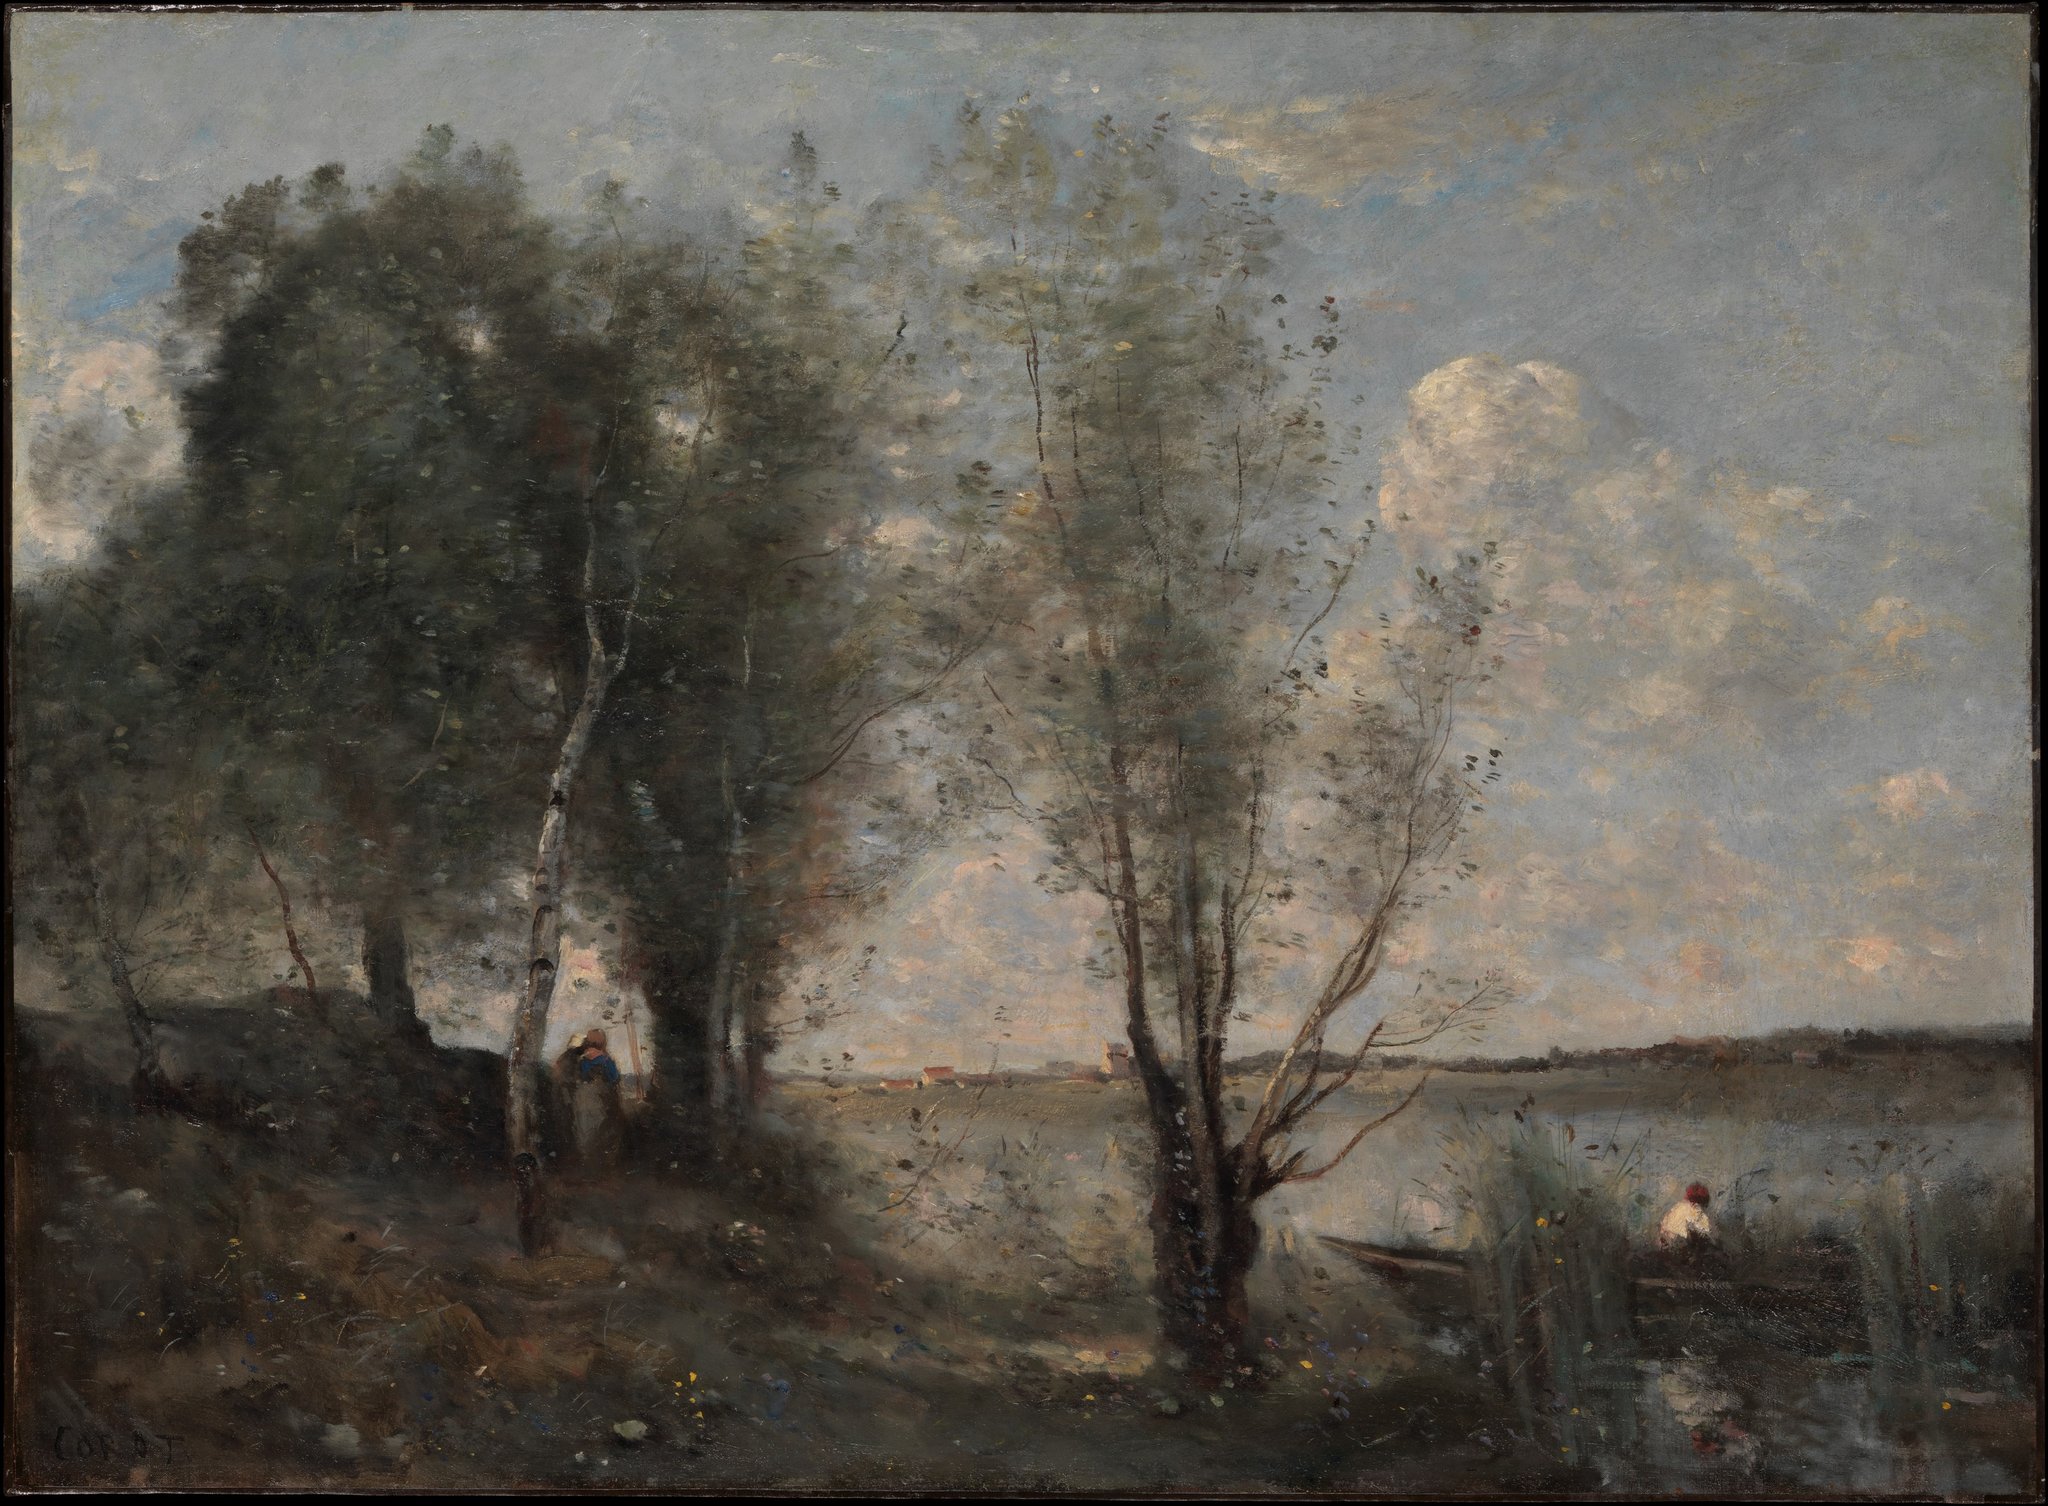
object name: painting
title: Boatman among the Reeds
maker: jean-baptiste-camille corot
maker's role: artist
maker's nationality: french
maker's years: 1796-1875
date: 1865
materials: canvas, oil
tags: landscapes,boats